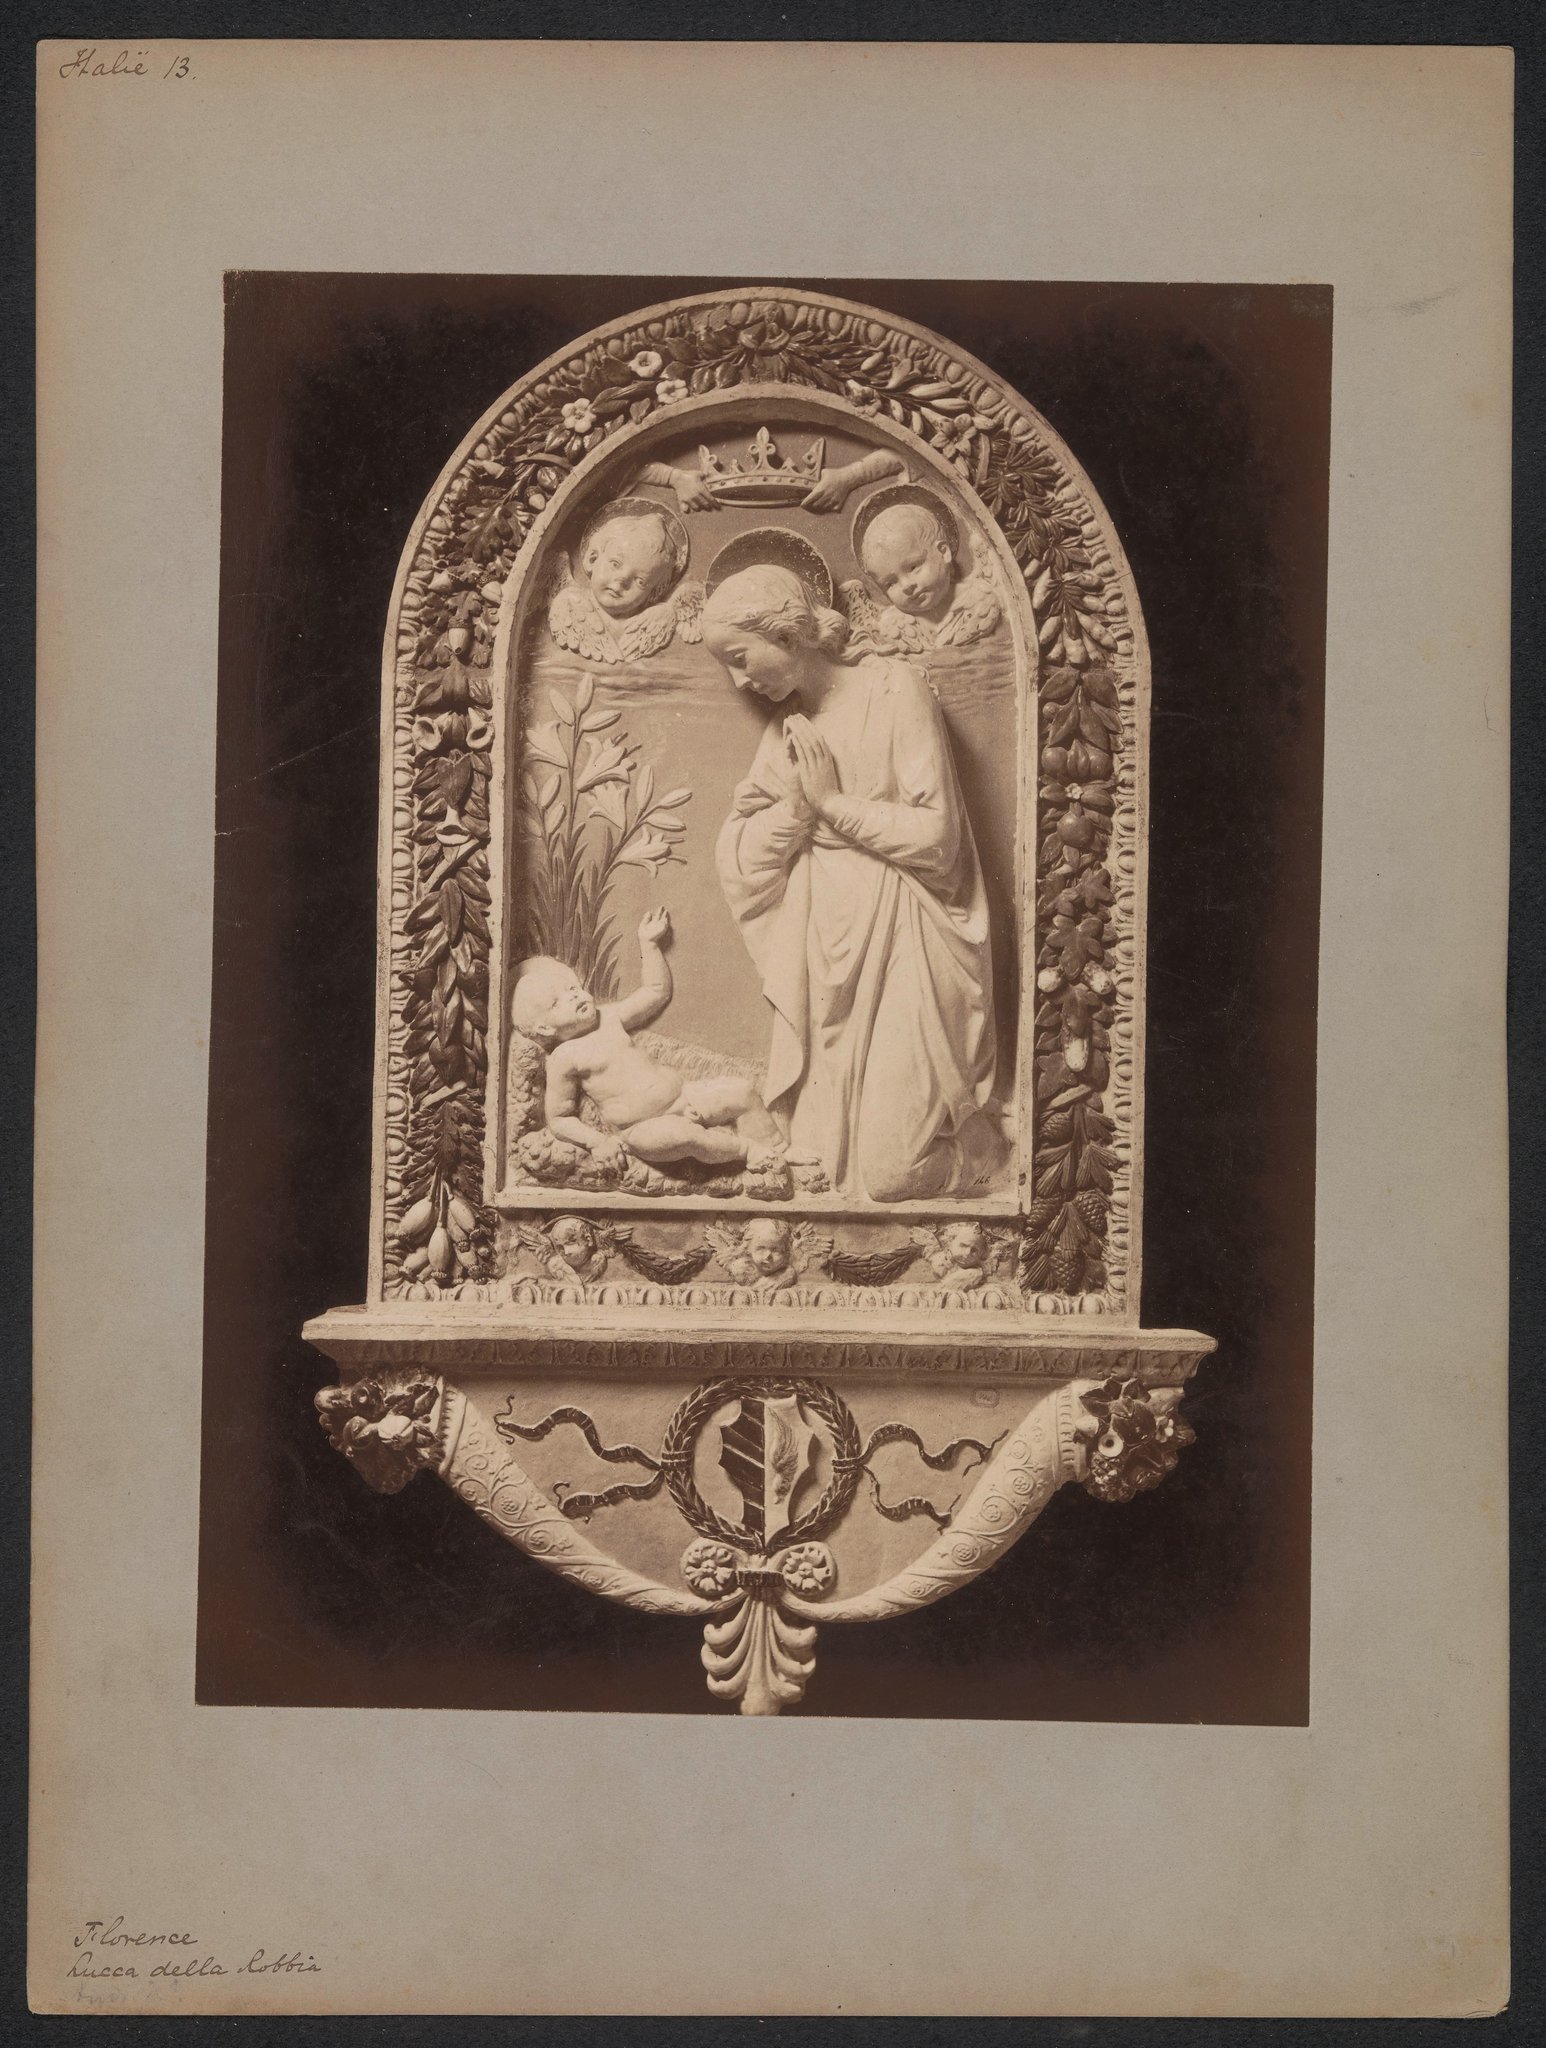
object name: photograph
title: De Aanbidding van Christus door Lucca della Robbia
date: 1850-1900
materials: cardboard, photographic support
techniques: albumen print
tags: adoration of the christ-child by mary, sculpture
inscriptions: collector's mark: ‘[RIJKS NORMAAL]SCHOOL voor T[EEKENONDERWIJZERS] AMSTER[DAM]’, annotation: ‘Florence/ Lucca della Robbia’, annotation: ‘Andrea?’, annotation: ‘Italië 13.’, annotation: ‘Florence/ Madonna in aan[bidding]/ [...] della Robbia’, check stamp: ‘ALINARI’